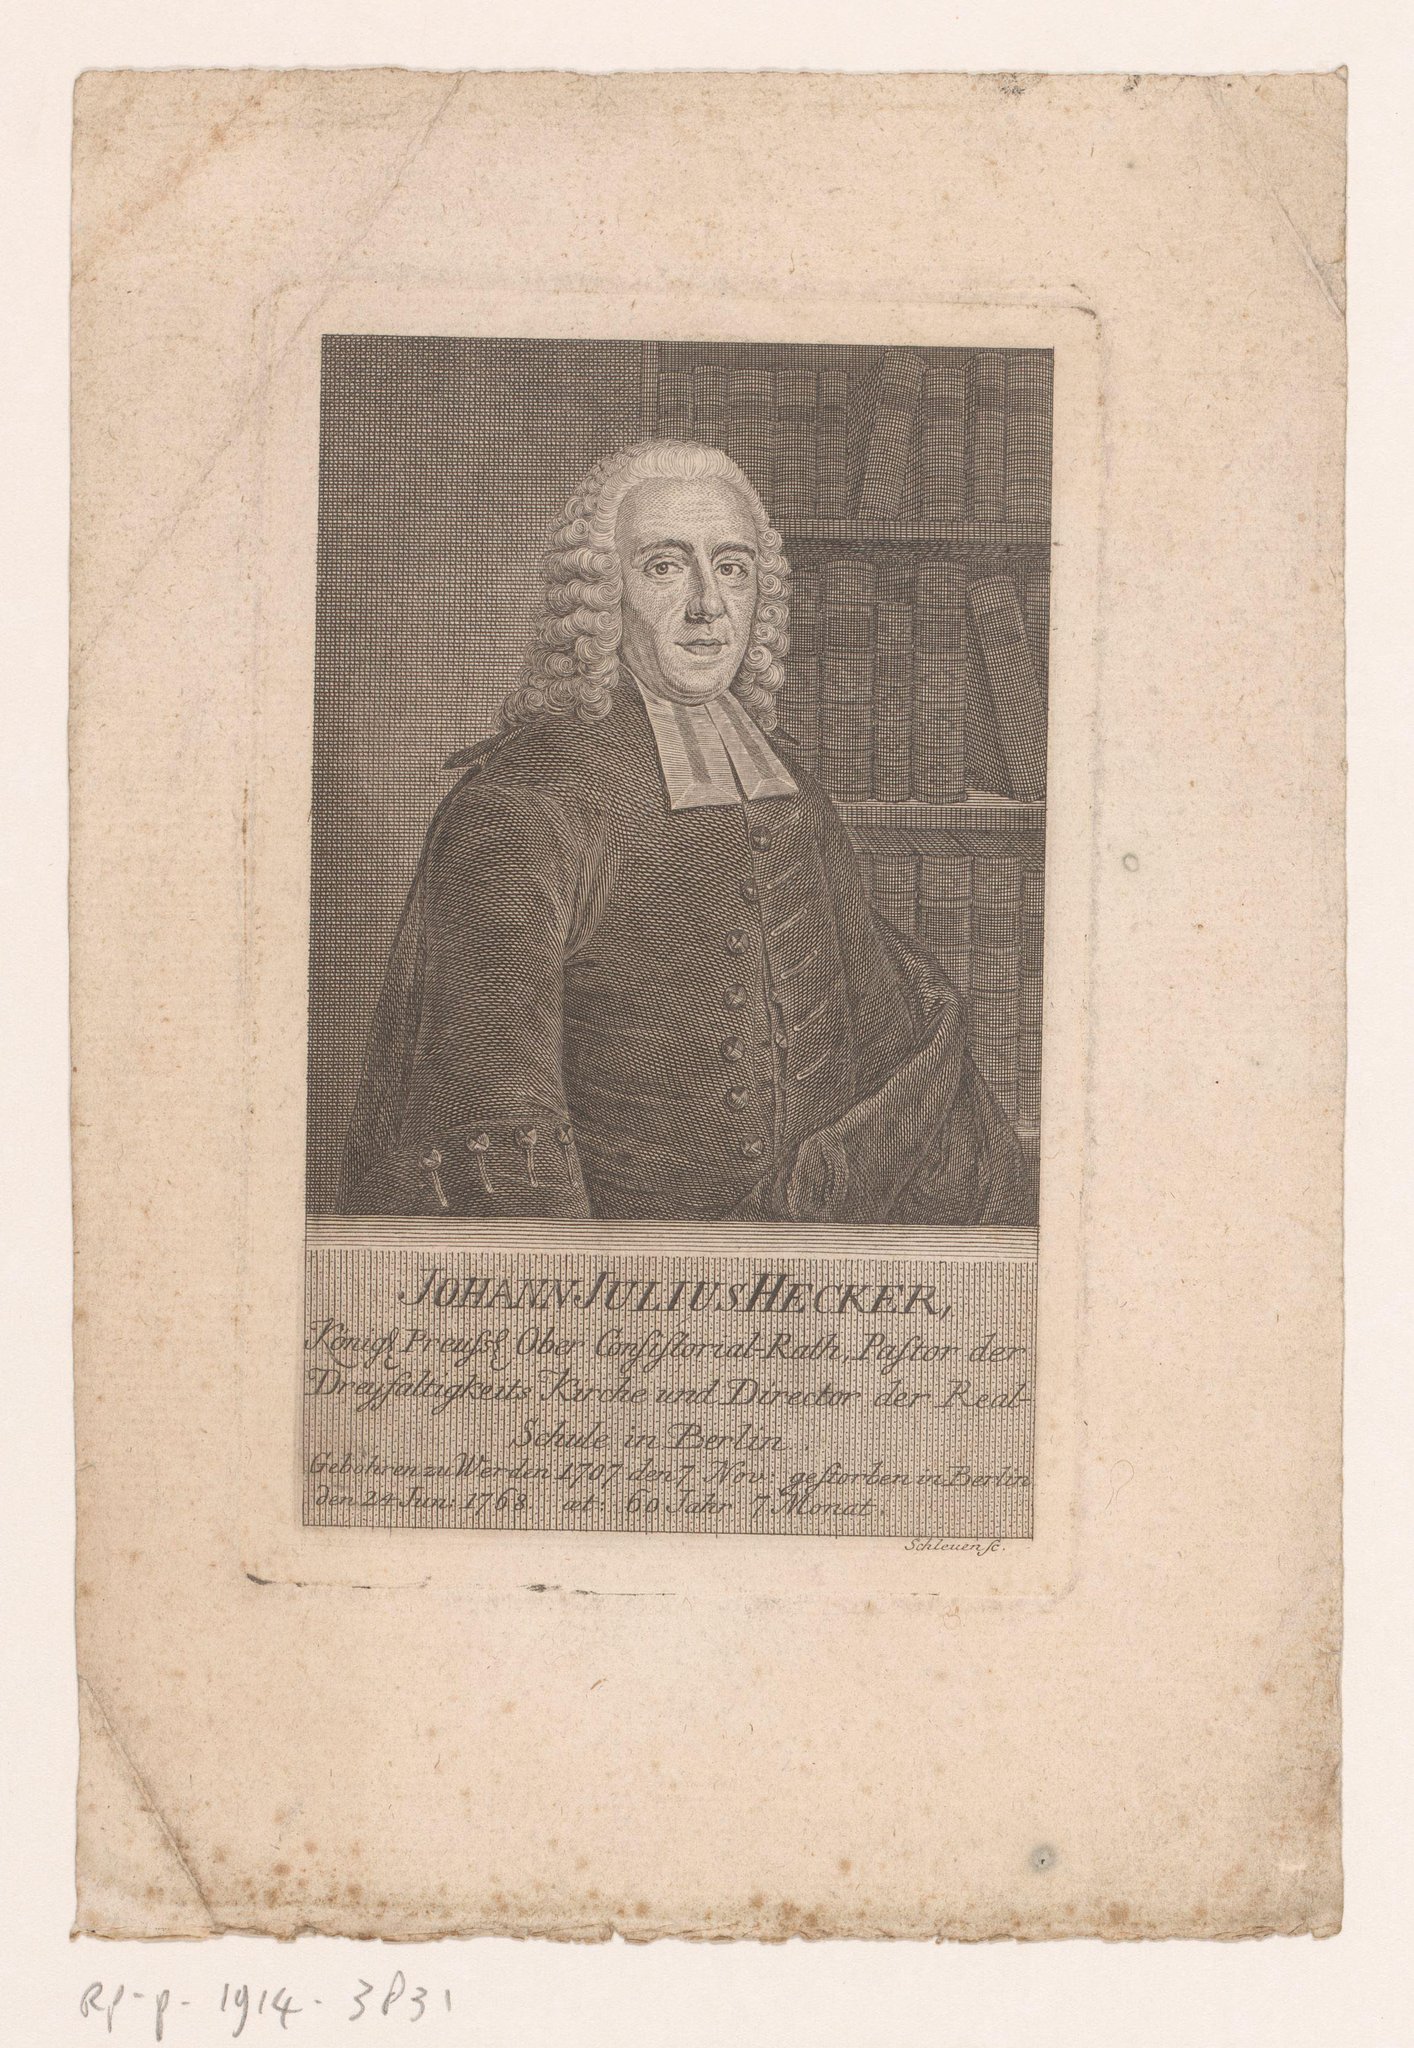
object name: print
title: Portret van Johann Julius Hecker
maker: johann friedrich schleuen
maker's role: print maker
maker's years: 1739-1784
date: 1768-1784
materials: paper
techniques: engraving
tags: essen, berlin, historical persons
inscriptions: collector's mark: Lugt 2228